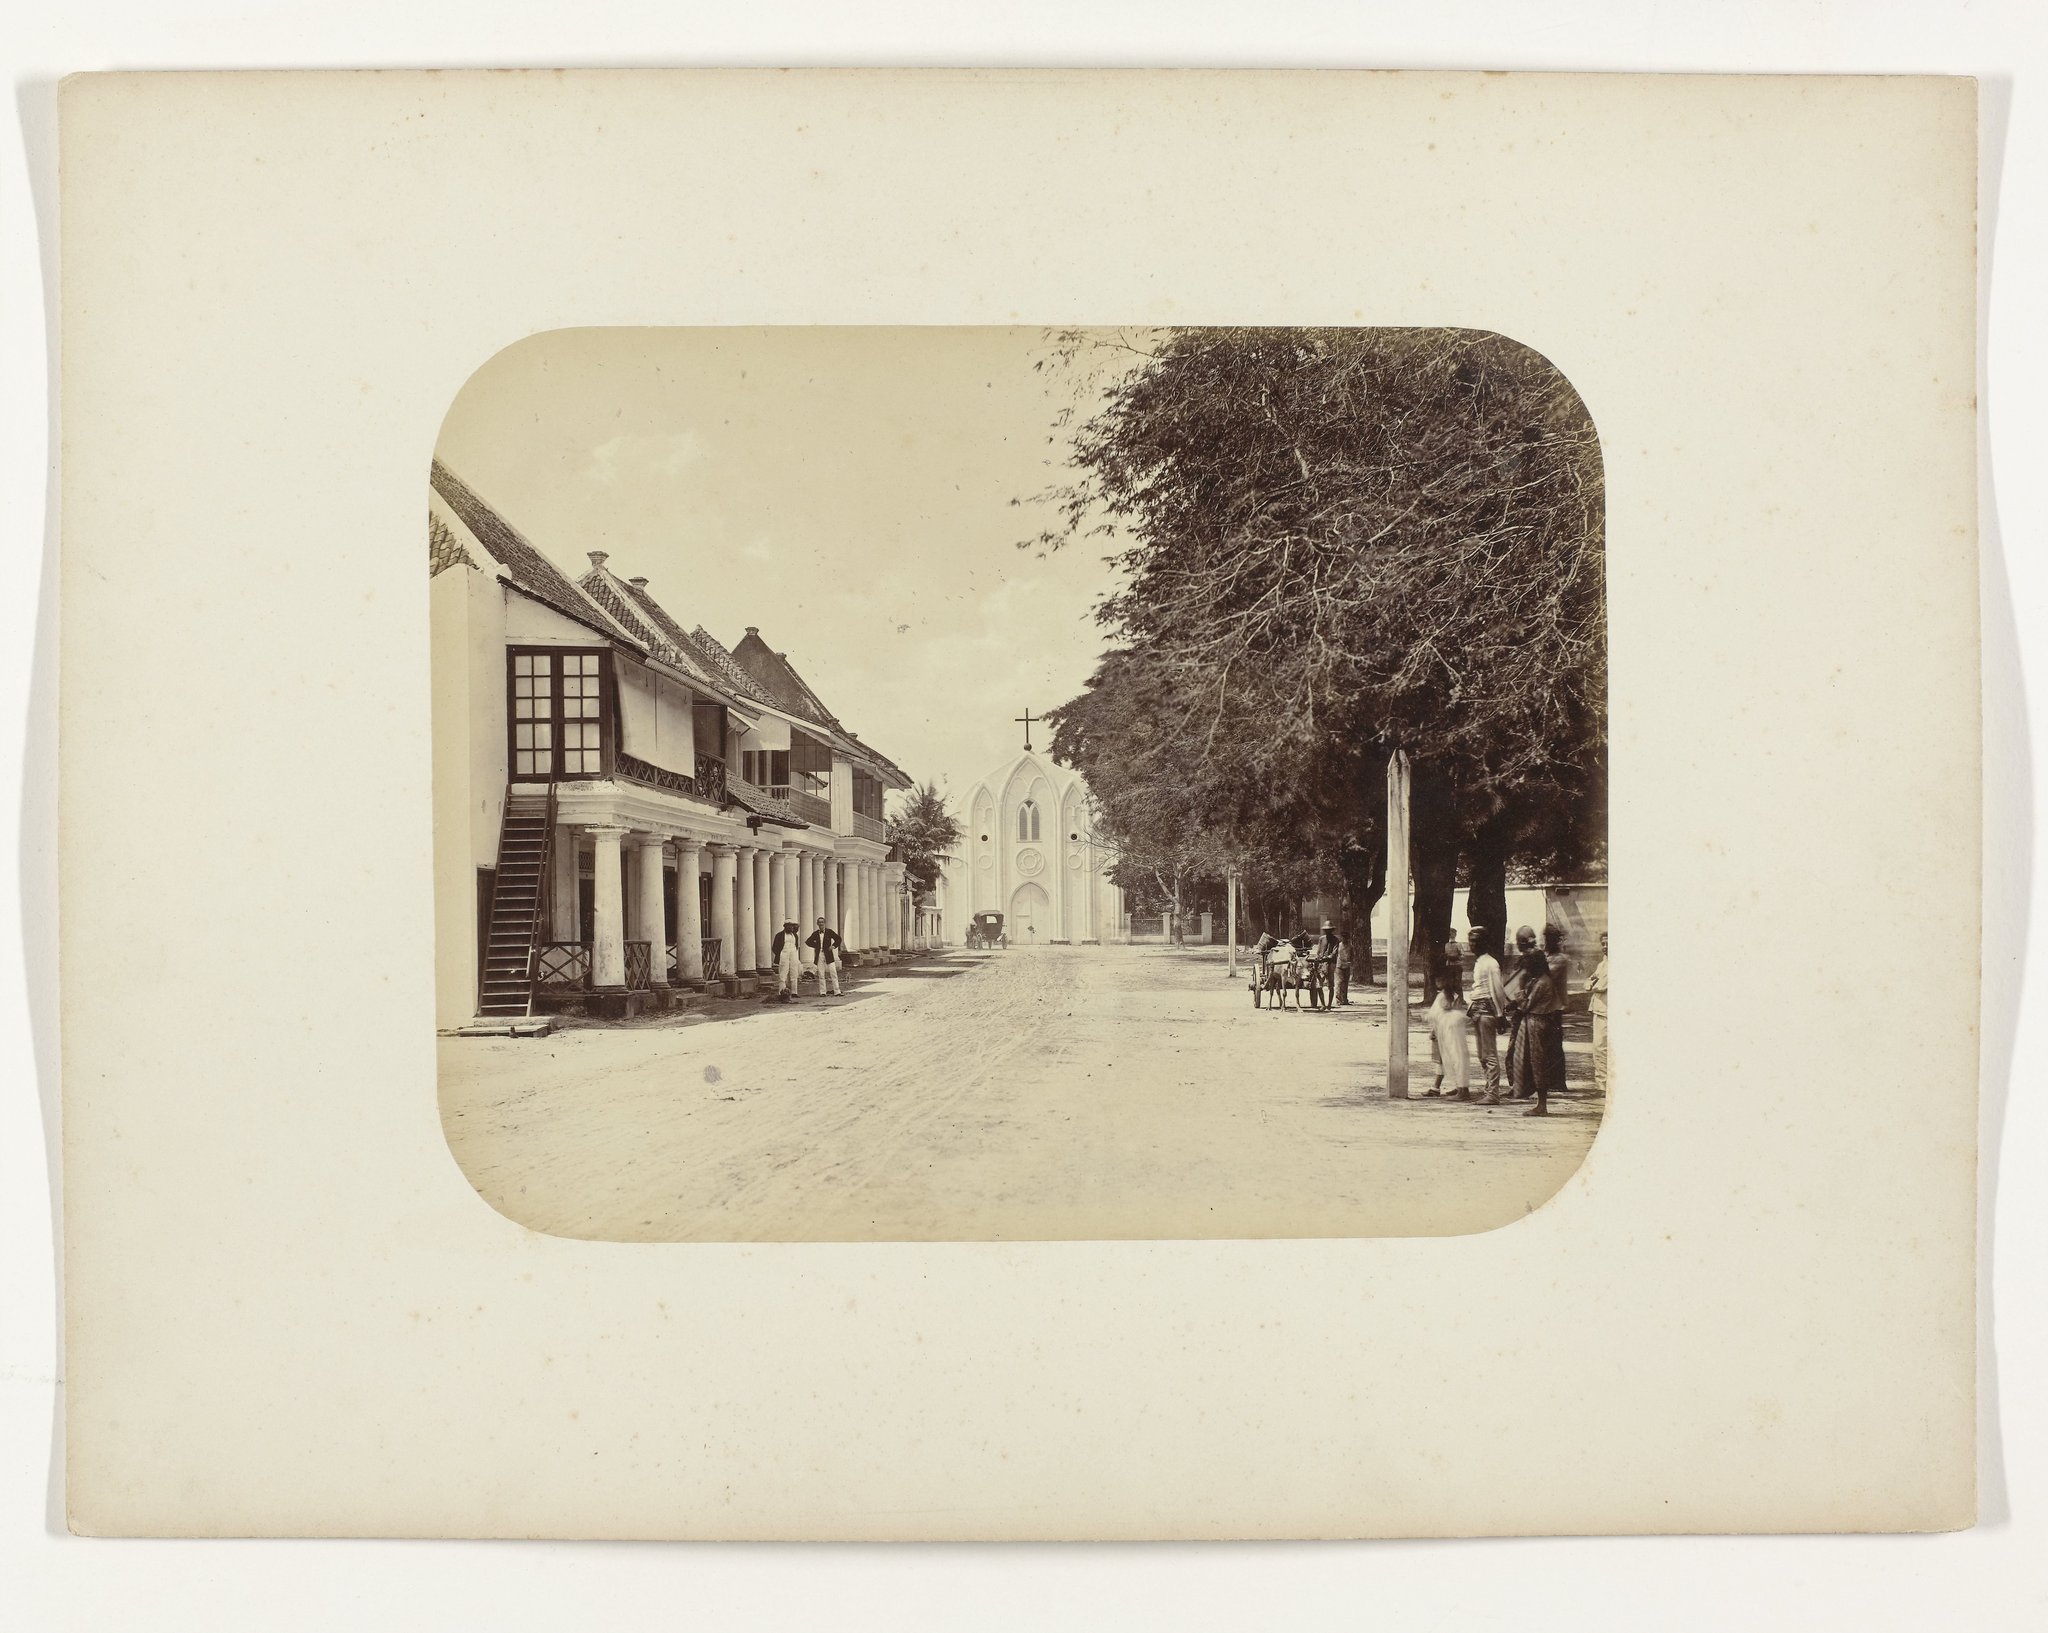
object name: photograph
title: De kathedraal van Surabaya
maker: herman salzwedel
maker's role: fotograaf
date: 1876-1884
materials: photographic support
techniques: albumen print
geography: surabaya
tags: utrecht, the hague, colonial system, church (exterior), surabaya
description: De kathedraal van Surabaya met links een huizenrij en rechts bomen. Voor de kathedraal staat een koets. Rechtsbeneden een aantal inlanders met iets verder een ossenkar met inlander. Voor de huizen enkele Europeanen en een liggende hond. Onderdeel van het fotoalbum door de Soerabayasche Vereeniging van Suikerfabrikanten aangeboden aan Frederik Beyerinck, resident van Soerabaja.